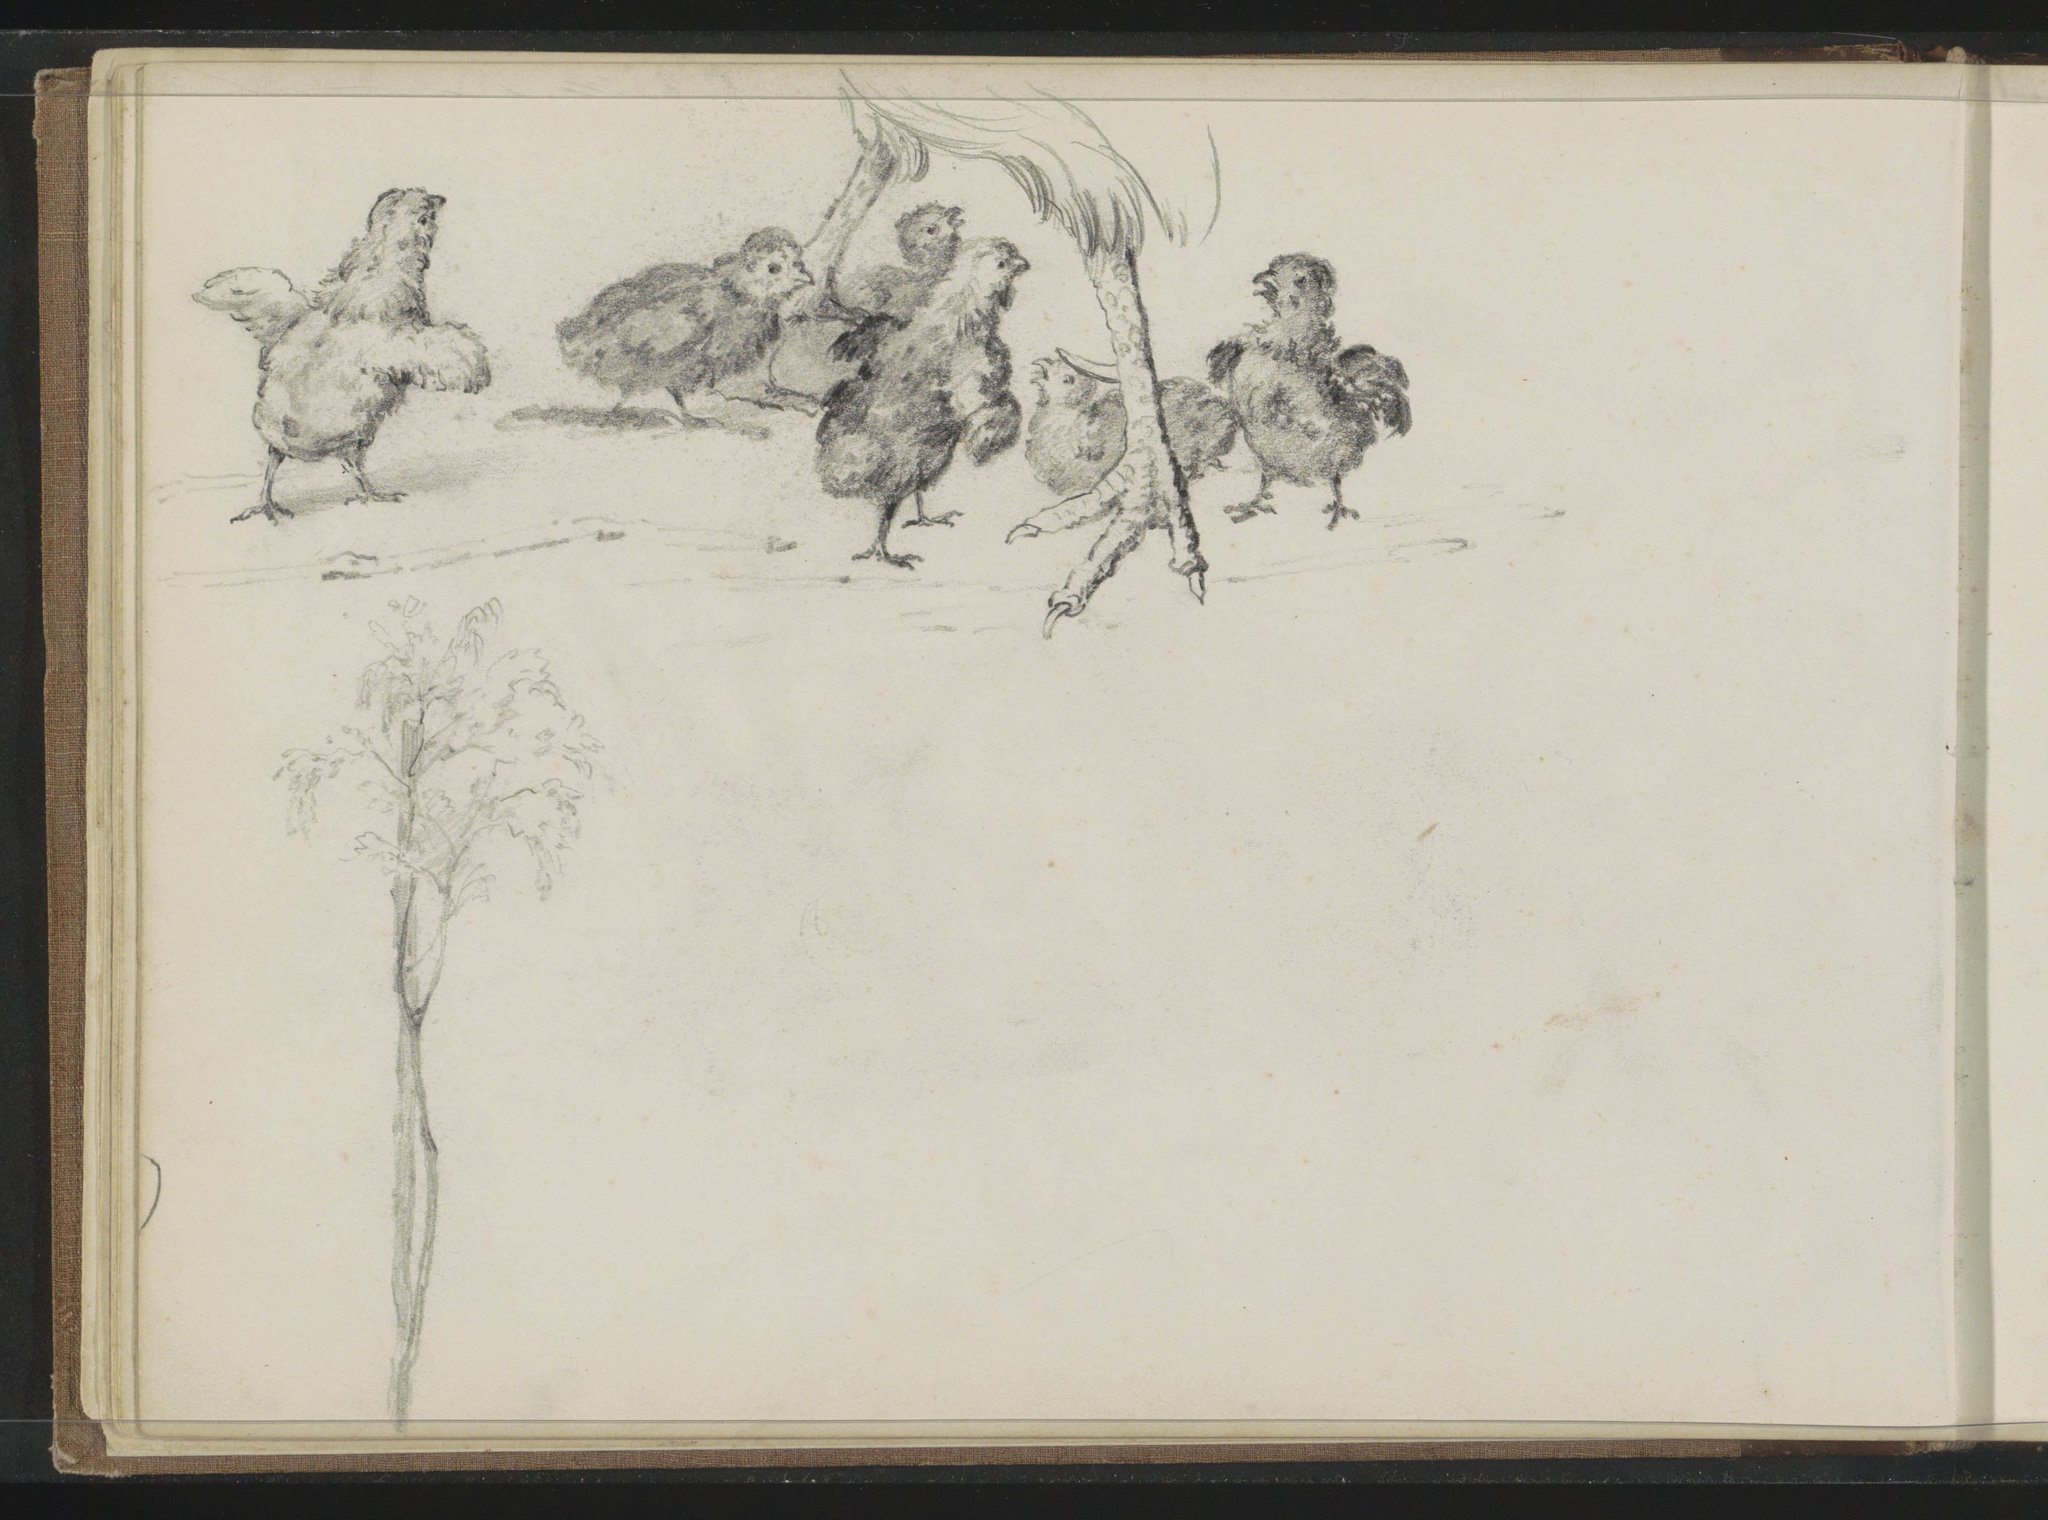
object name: sketchbook leaf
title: Kuikens tussen de poten van een kip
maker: hendrik valkenburg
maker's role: draughtsman, painter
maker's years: 1826-1896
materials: paper, pencil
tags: trees, fowl (cock, hen, chicken, etc.) (+ young animal)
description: Tevens een studie van een boom. Blad 15 verso uit een schetsboek met 77 bladen.